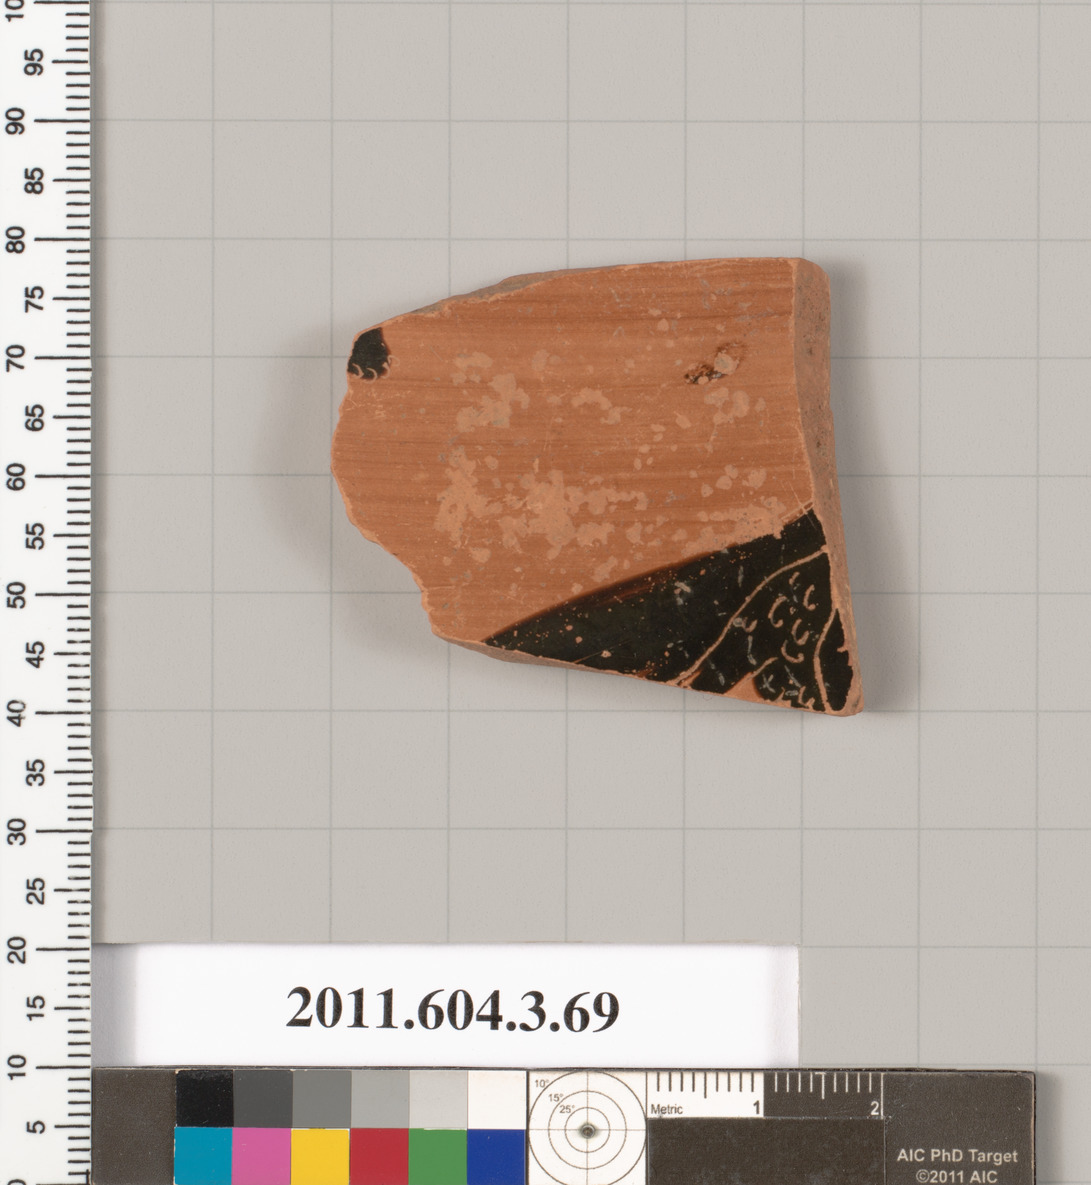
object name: amphora fragment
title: Terracotta fragment of an amphora (jar)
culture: greek, attic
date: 530-520 BCE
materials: terracotta